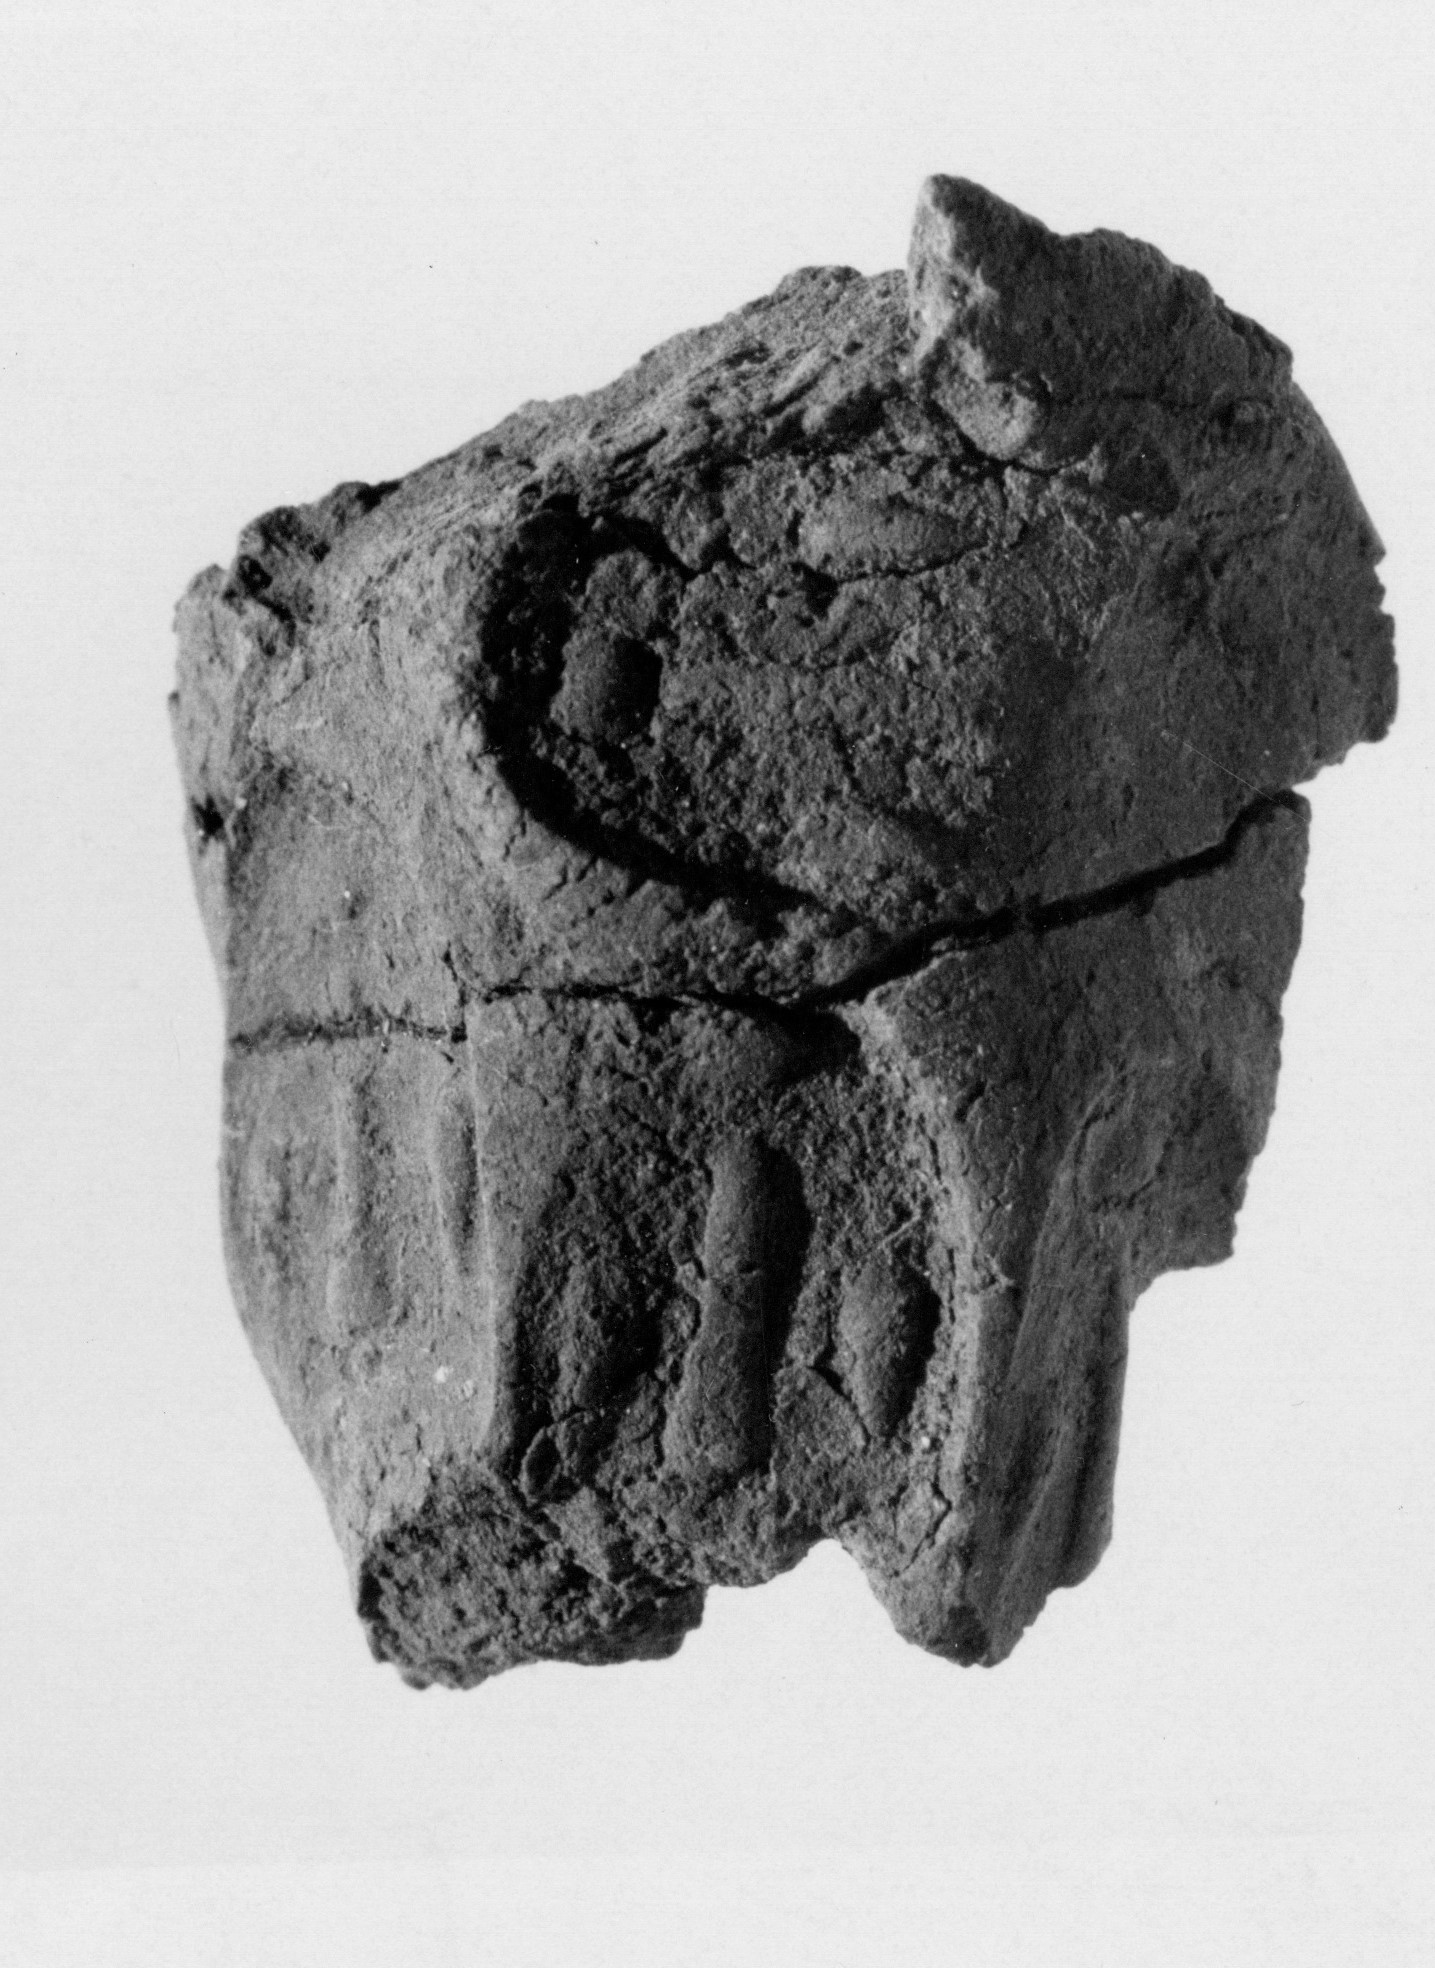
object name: sealing, djed, cobra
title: Document Sealing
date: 1390-1352 BCE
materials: mud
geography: egypt